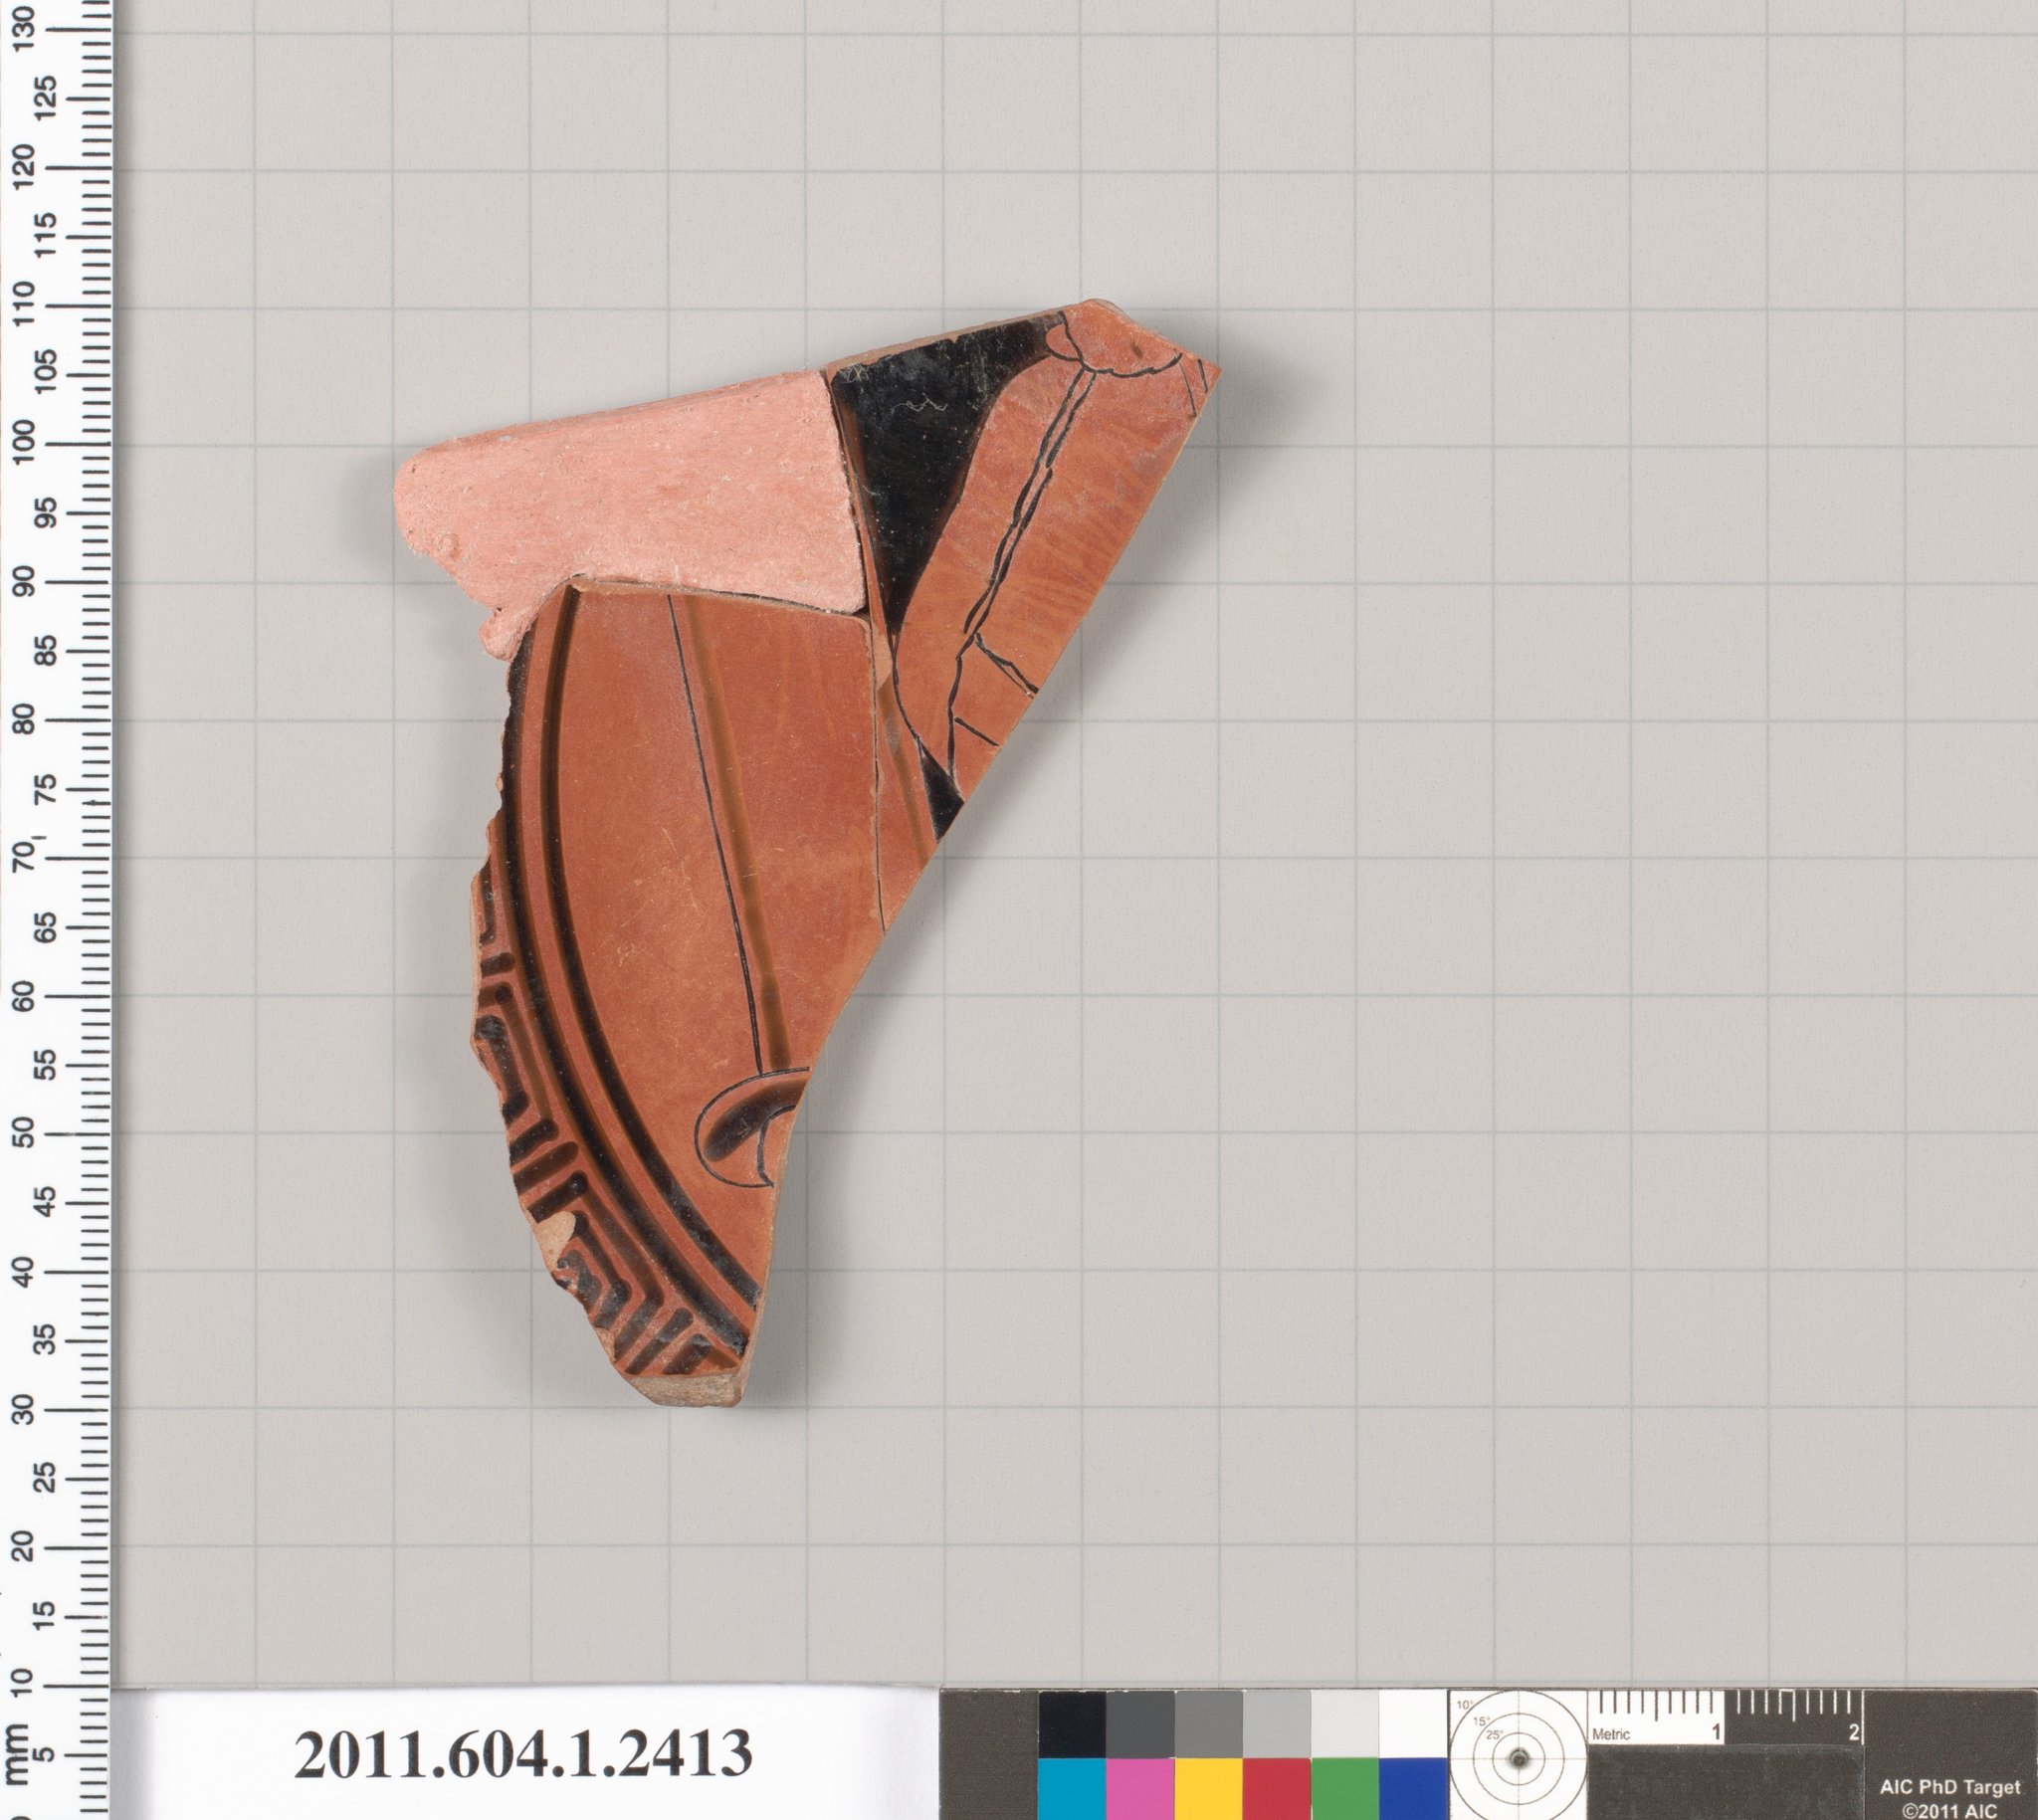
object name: kylix fragment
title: Terracotta fragment of a kylix (drinking cup)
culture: greek, attic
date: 490-480 BCE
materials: terracotta